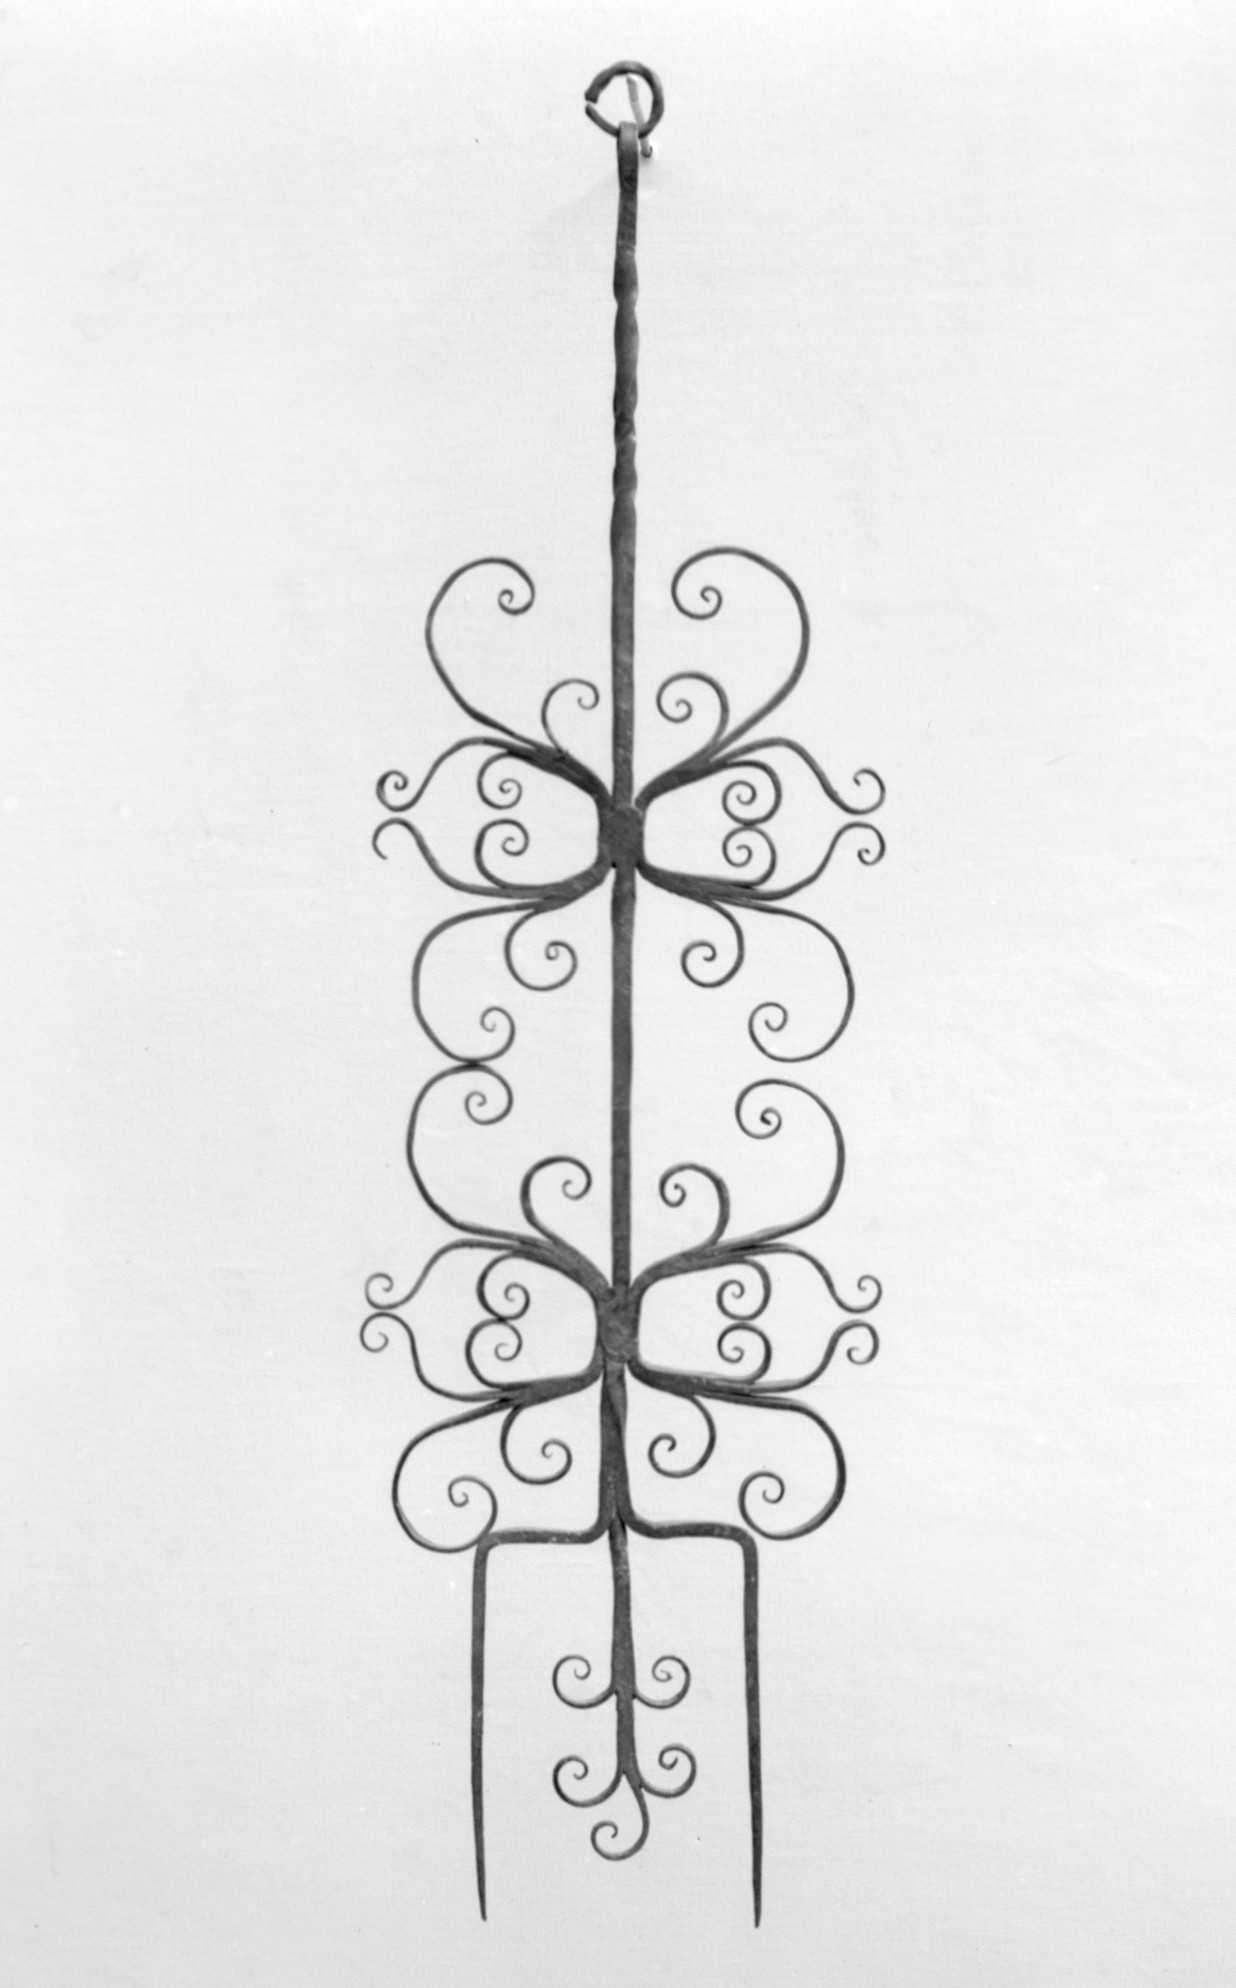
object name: fork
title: Broaching or toasting fork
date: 1601-1700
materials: iron